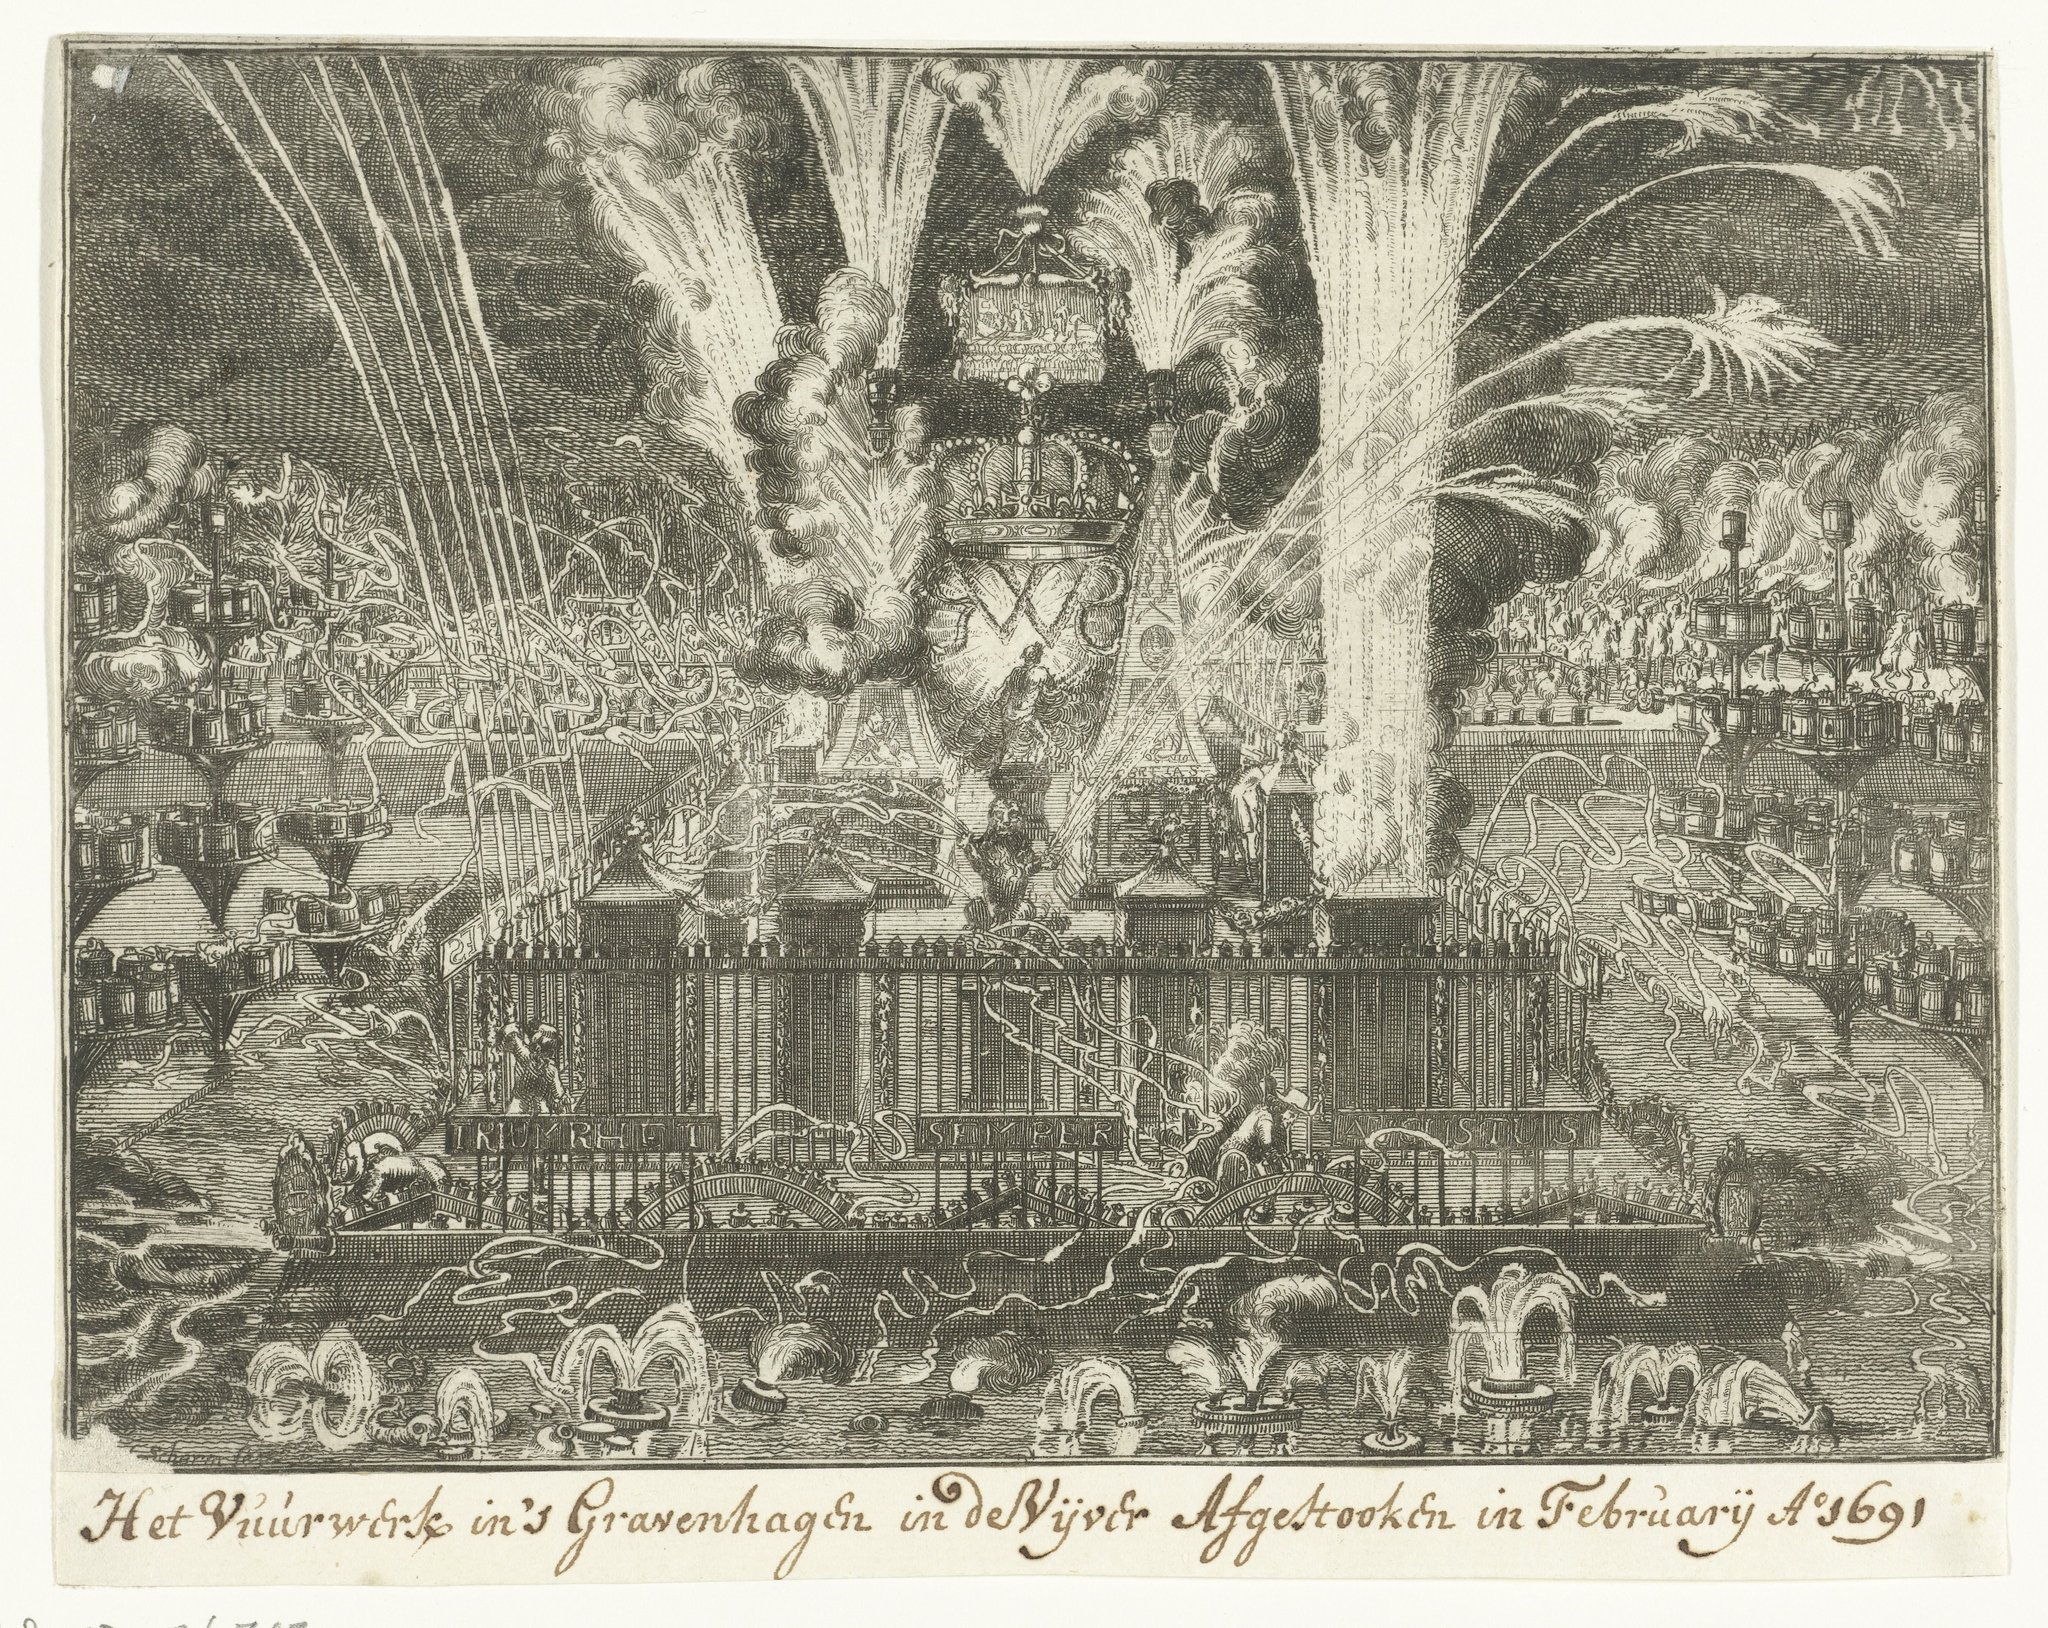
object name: print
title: Vuurwerk te Den Haag, 1691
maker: laurens scherm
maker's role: draughtsman, print maker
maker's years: 1671-1702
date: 1691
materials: paper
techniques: etching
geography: amsterdam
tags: william iii (prince of orange and king of england, scotland, and ireland), bonfire, fire-works, the hague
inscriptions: inscription: ‘Het Vuurwerk in 's Gravenhagen in de Vijver Afgestooken in February Ao 1691’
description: Vuurwerk afgestoken op het water ter gelegenheid van de intocht van koning Willem III te Den Haag, 5 februari 1691. Plaat nr. 18 in de serie 'Engelands schouwtoneel' over de oorlog tussen Willem III en Jacobus II in de jaren 1690-1691 na de Glorious Revolution, (derde deel). Dit afgeknipte exemplaat zonder de onderschriften in het Nederlands en Frans, maar met een handgeschreven onderschrift.